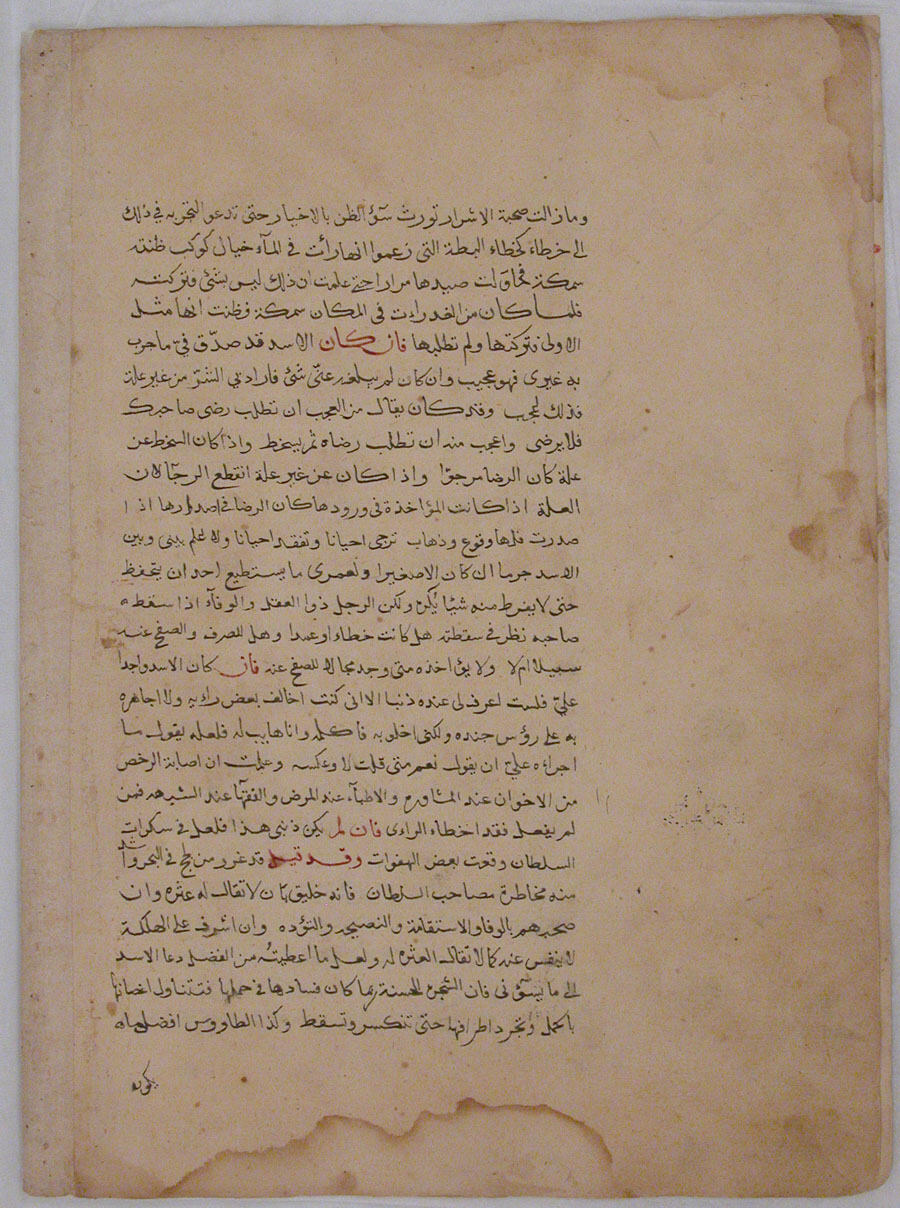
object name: folio from an illustrated manuscript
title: Page of Calligraphy from a Kalila wa Dimna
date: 1526-1550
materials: ink, paper, watercolor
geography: india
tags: arabic,calligraphy